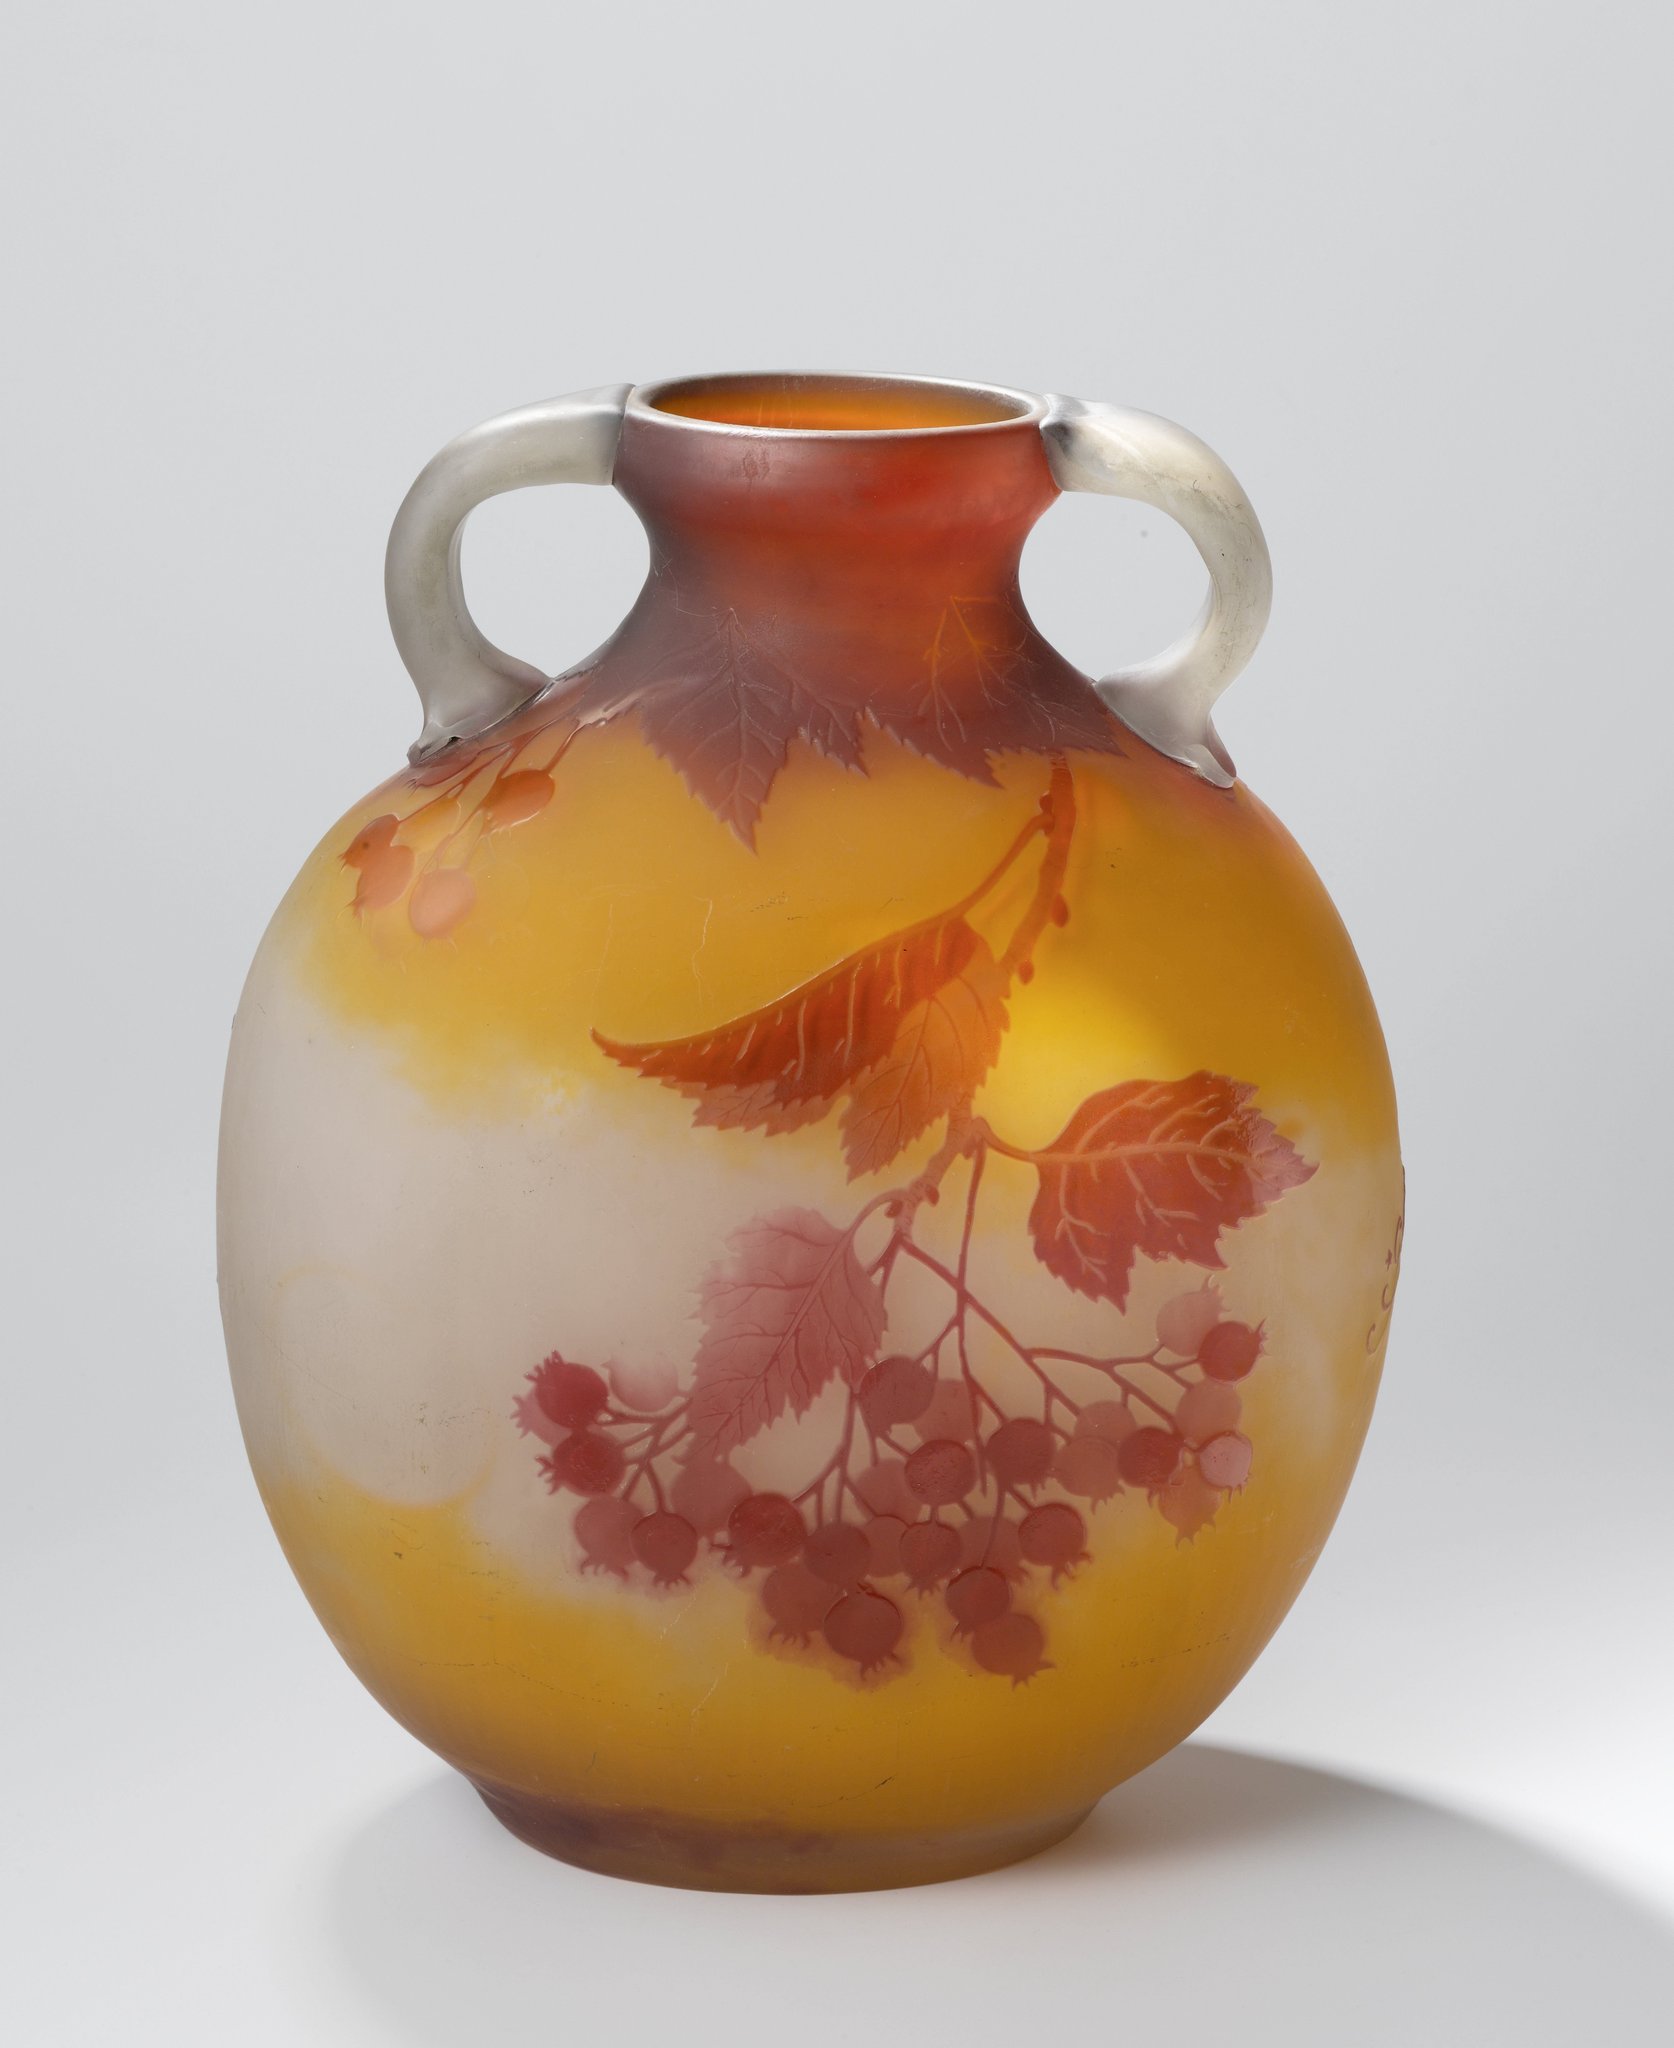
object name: vase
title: Vaas met ahorntakken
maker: émile gallé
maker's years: 1846-1904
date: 1904-1906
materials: glass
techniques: etching, glassblowing, grinding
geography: nancy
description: Concave, geslepen bodem, afgeplat bolvormig lichaam van kleurloos glas, uitlopend in een lange hals. Dubbele Überfang in oranje en rood op een gele en kleurloze ondergrond. Decor van ahorntakken met bessen, deels mat geëtst. Op het lichaam de signatuur Gallé met een *.